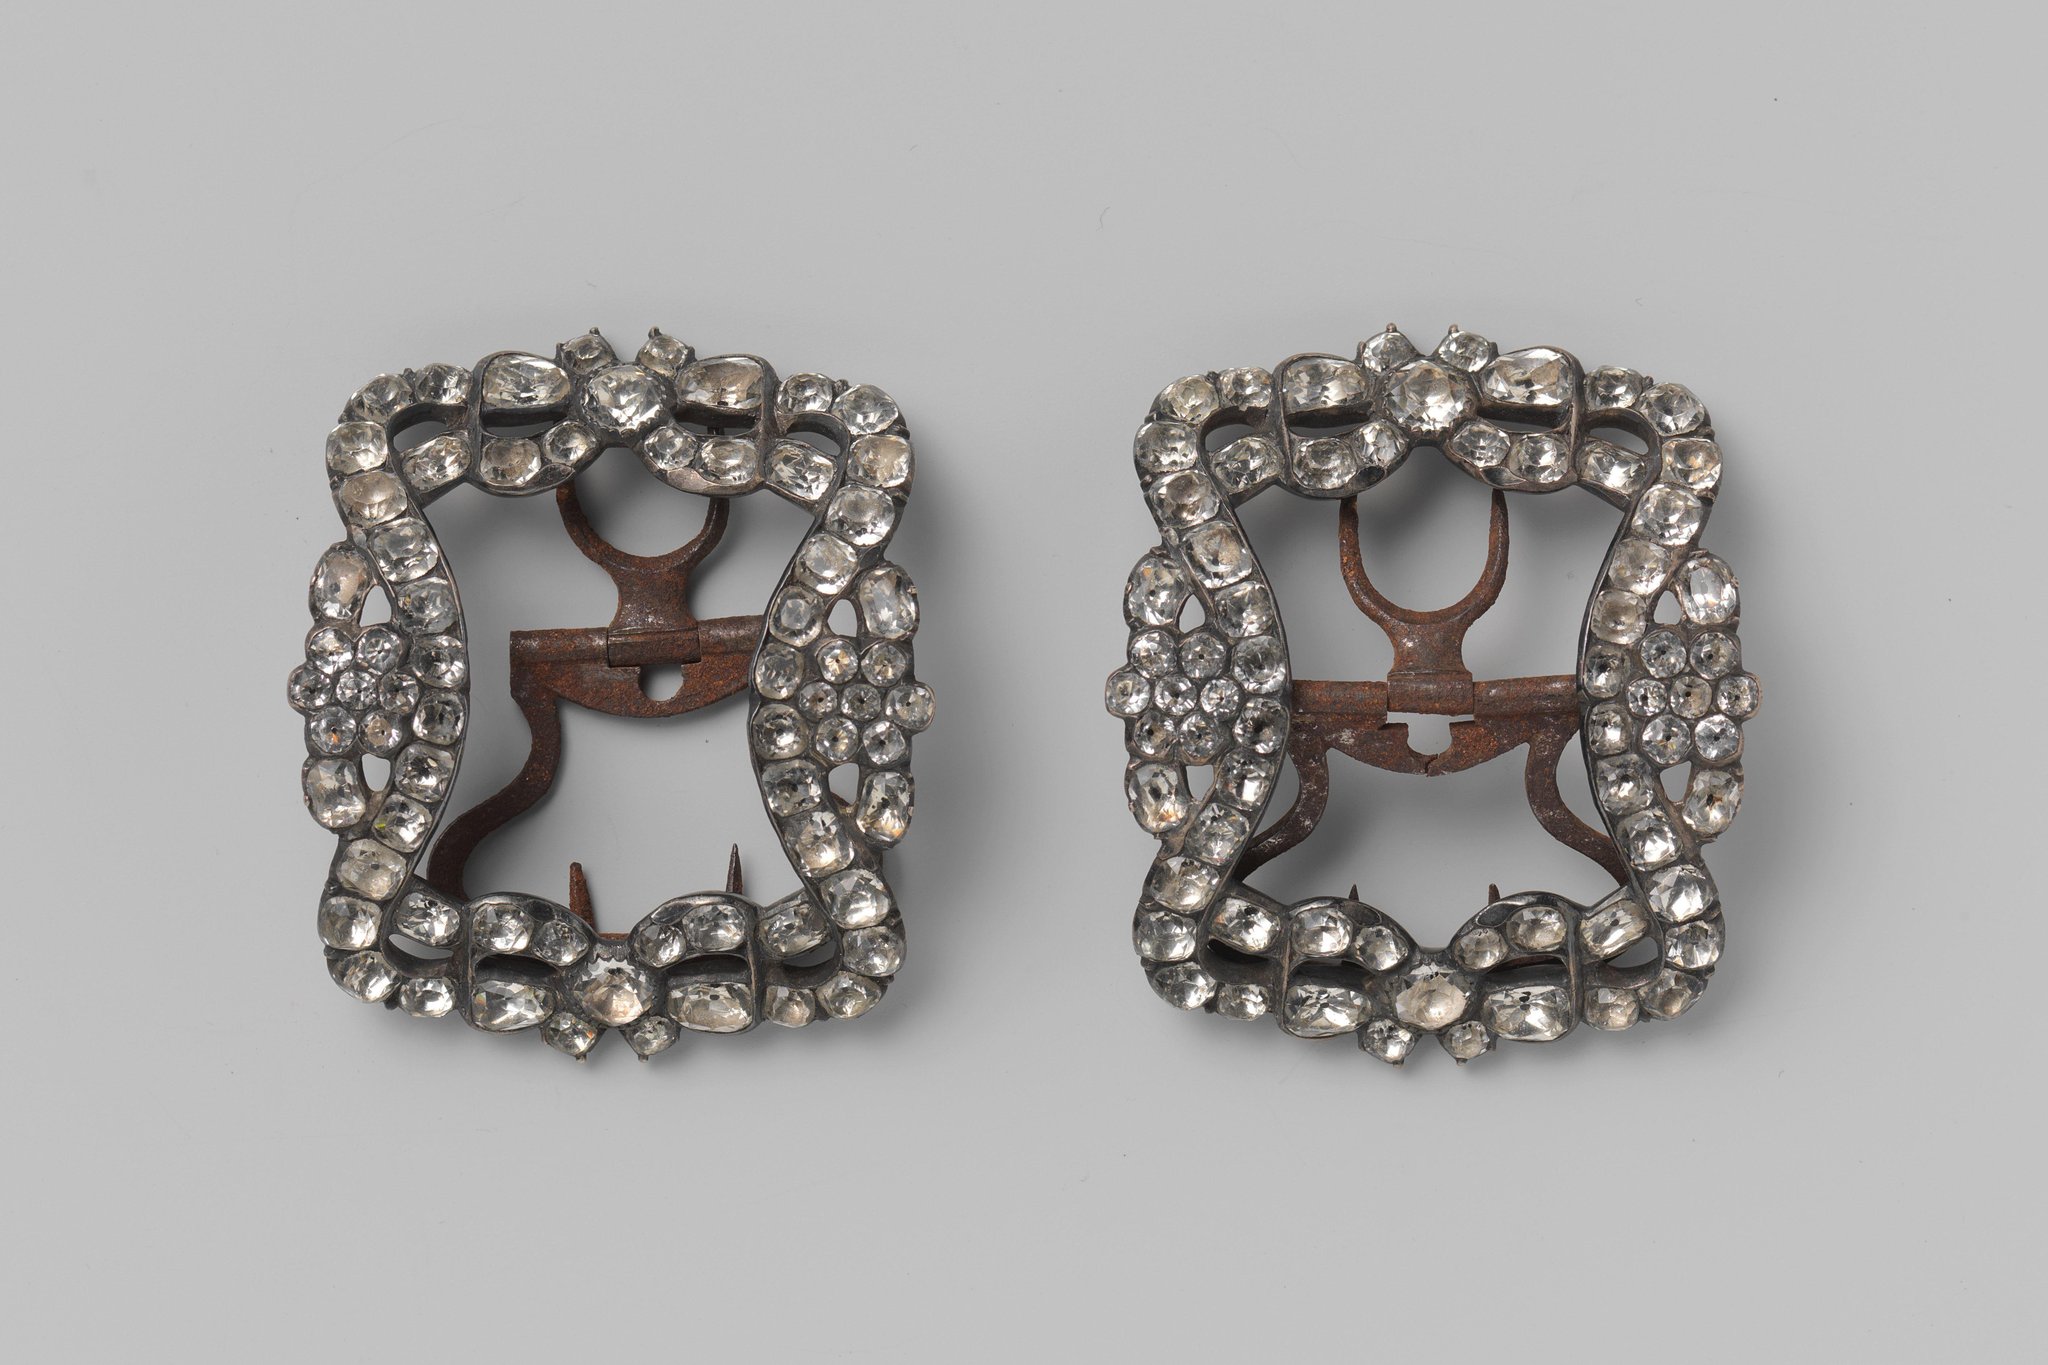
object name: shoe buckle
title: Schoengesp van stras met stalen pin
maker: Anonymous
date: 1400-1950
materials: paste, steel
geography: western europe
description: Schoengesp van stras met een stalen pin, gedecoreerd met twee bloemen en twee strikken.